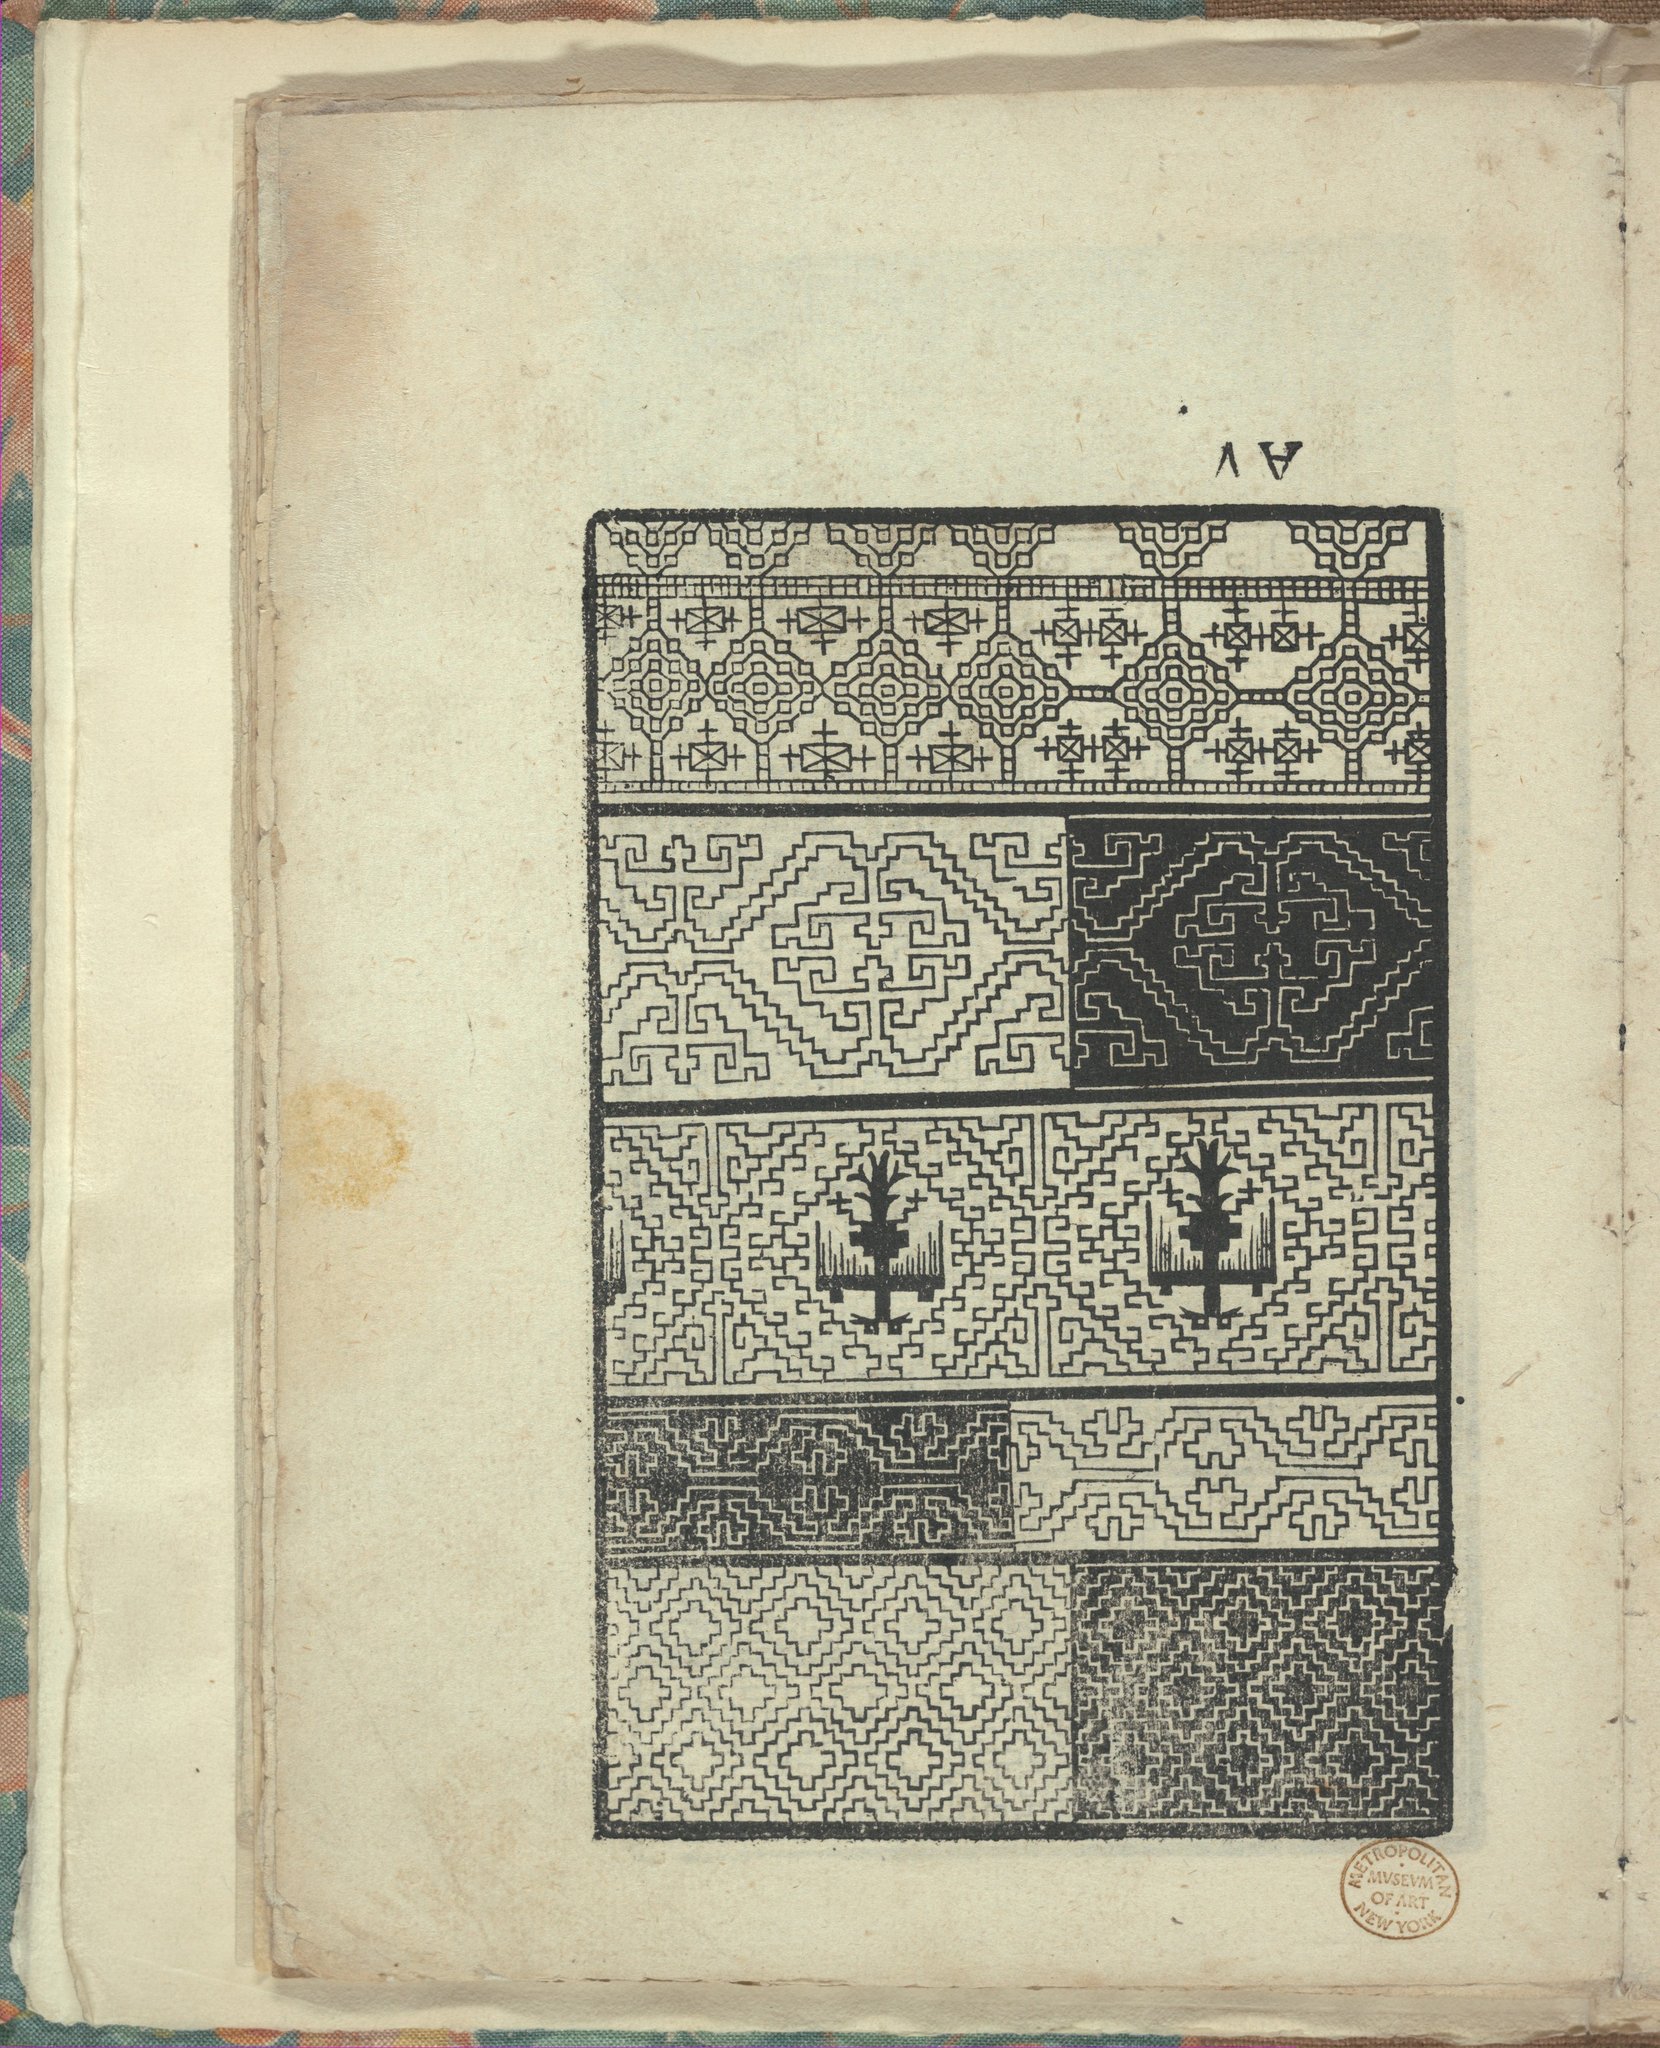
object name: book print ornament architecture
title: Opera Nova Universali intitulata Corona di racammi, page 17 (verso)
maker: giovanni andrea vavassore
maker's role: publisher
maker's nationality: italian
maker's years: 1530-1573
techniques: woodcut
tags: ornament